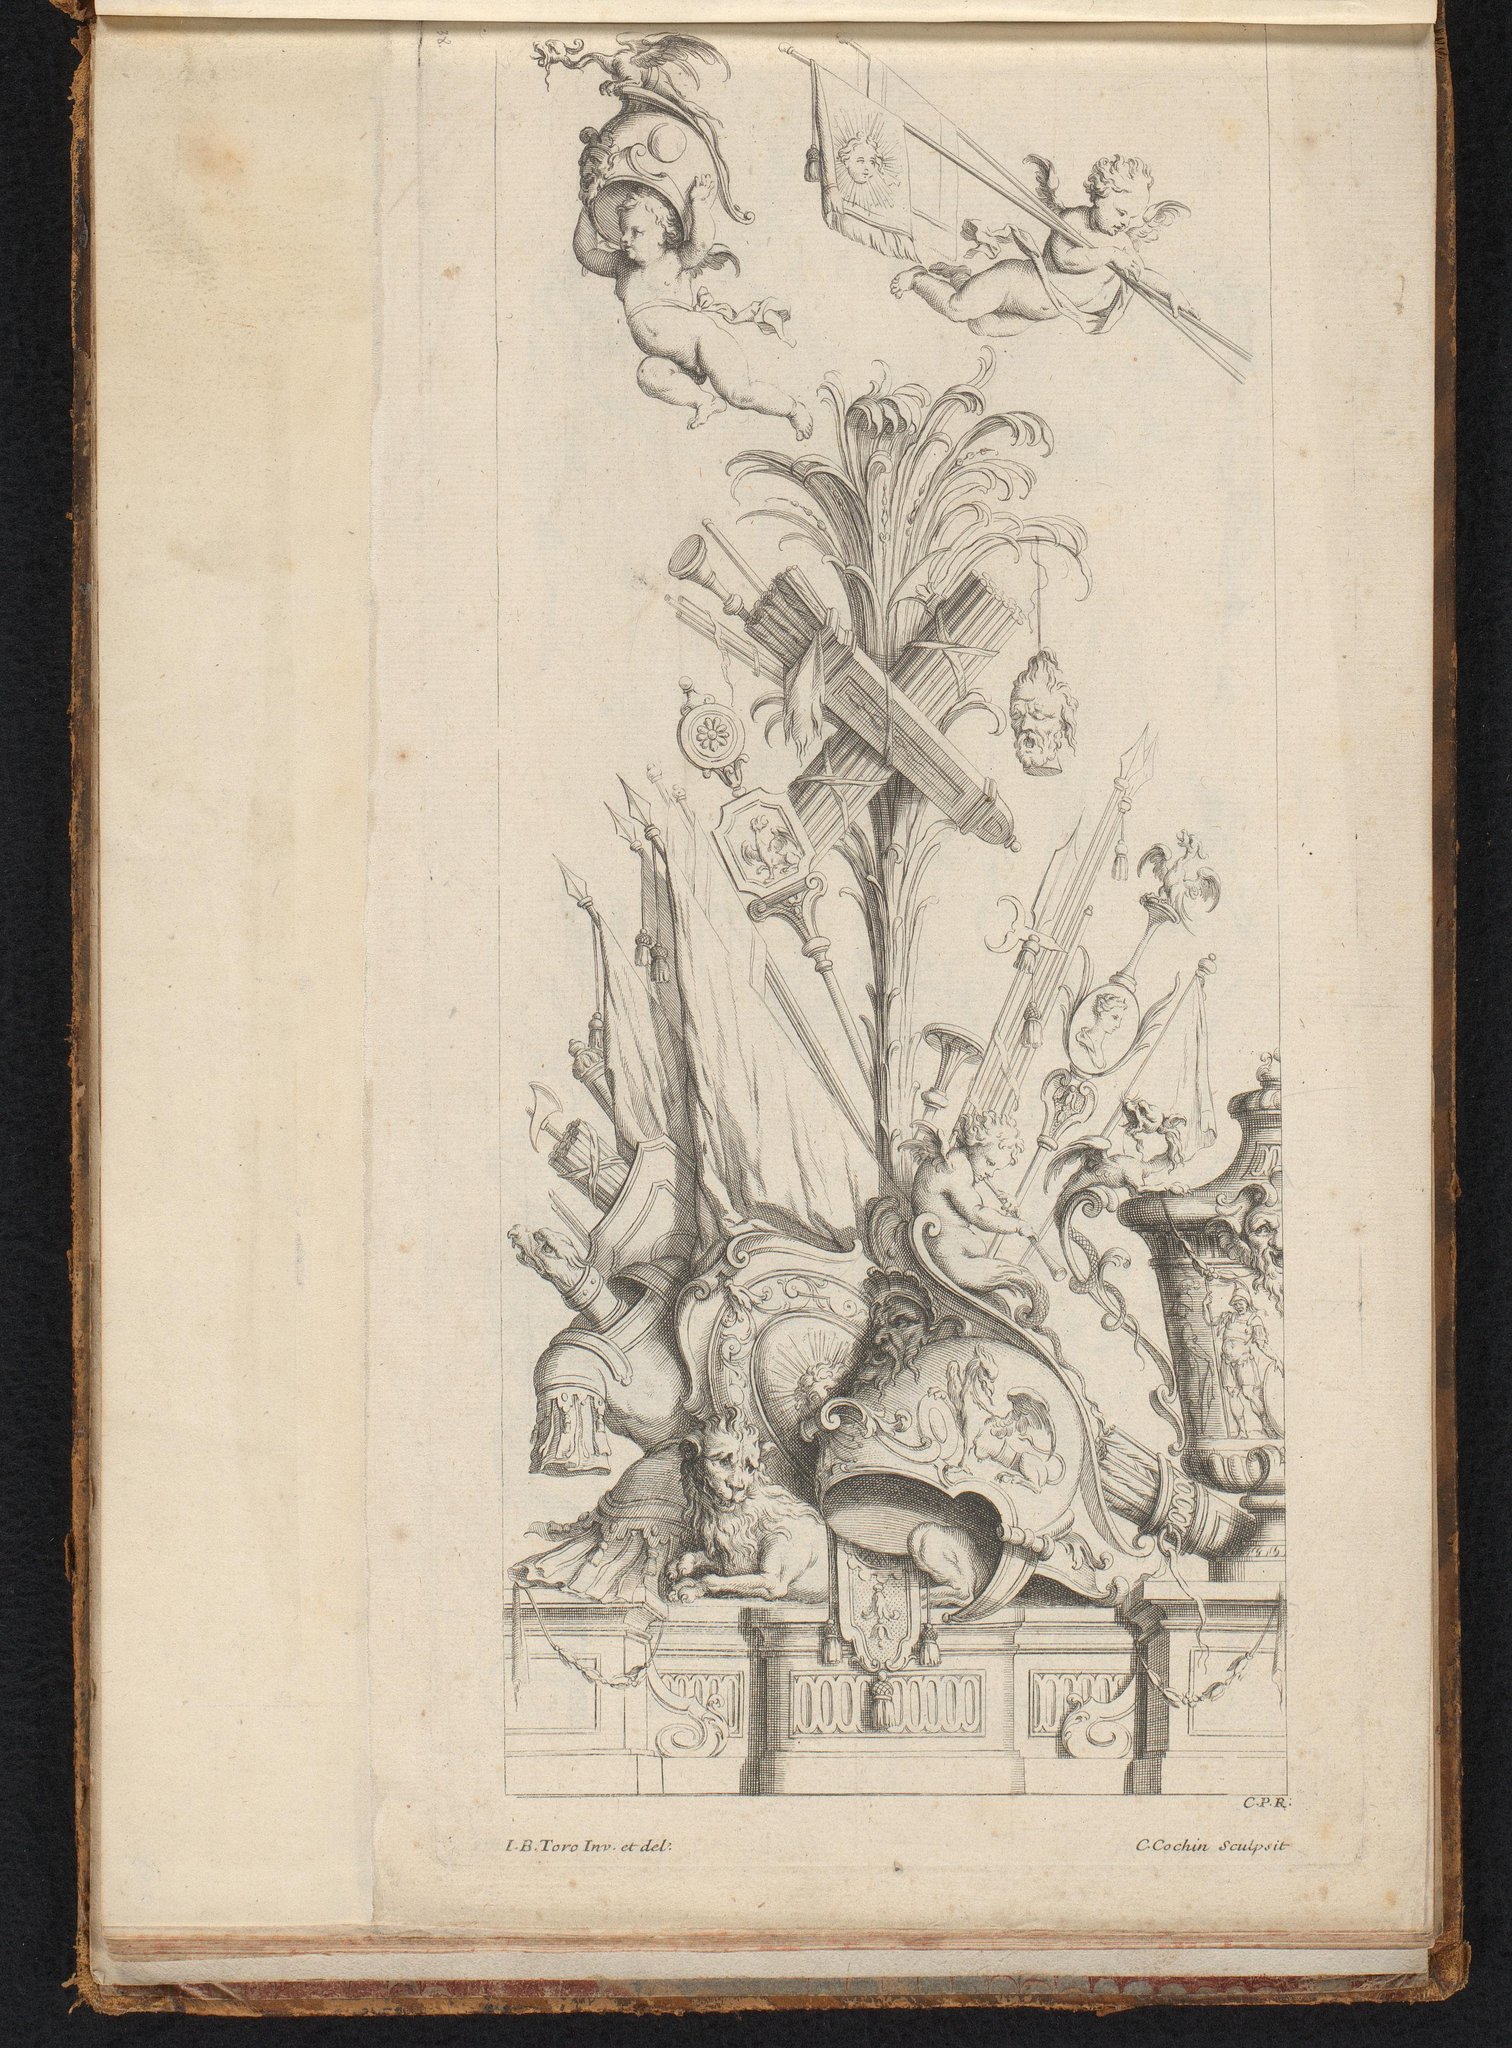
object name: album leaf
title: Trofee met putti en wapens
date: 1716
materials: paper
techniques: engraving, etching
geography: france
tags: 'tropaion', i.e. decorative ornament ~ weapons, cupids: 'amores', 'amoretti', 'putti'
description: Prent maakt deel uit van een serie van zes prenten.